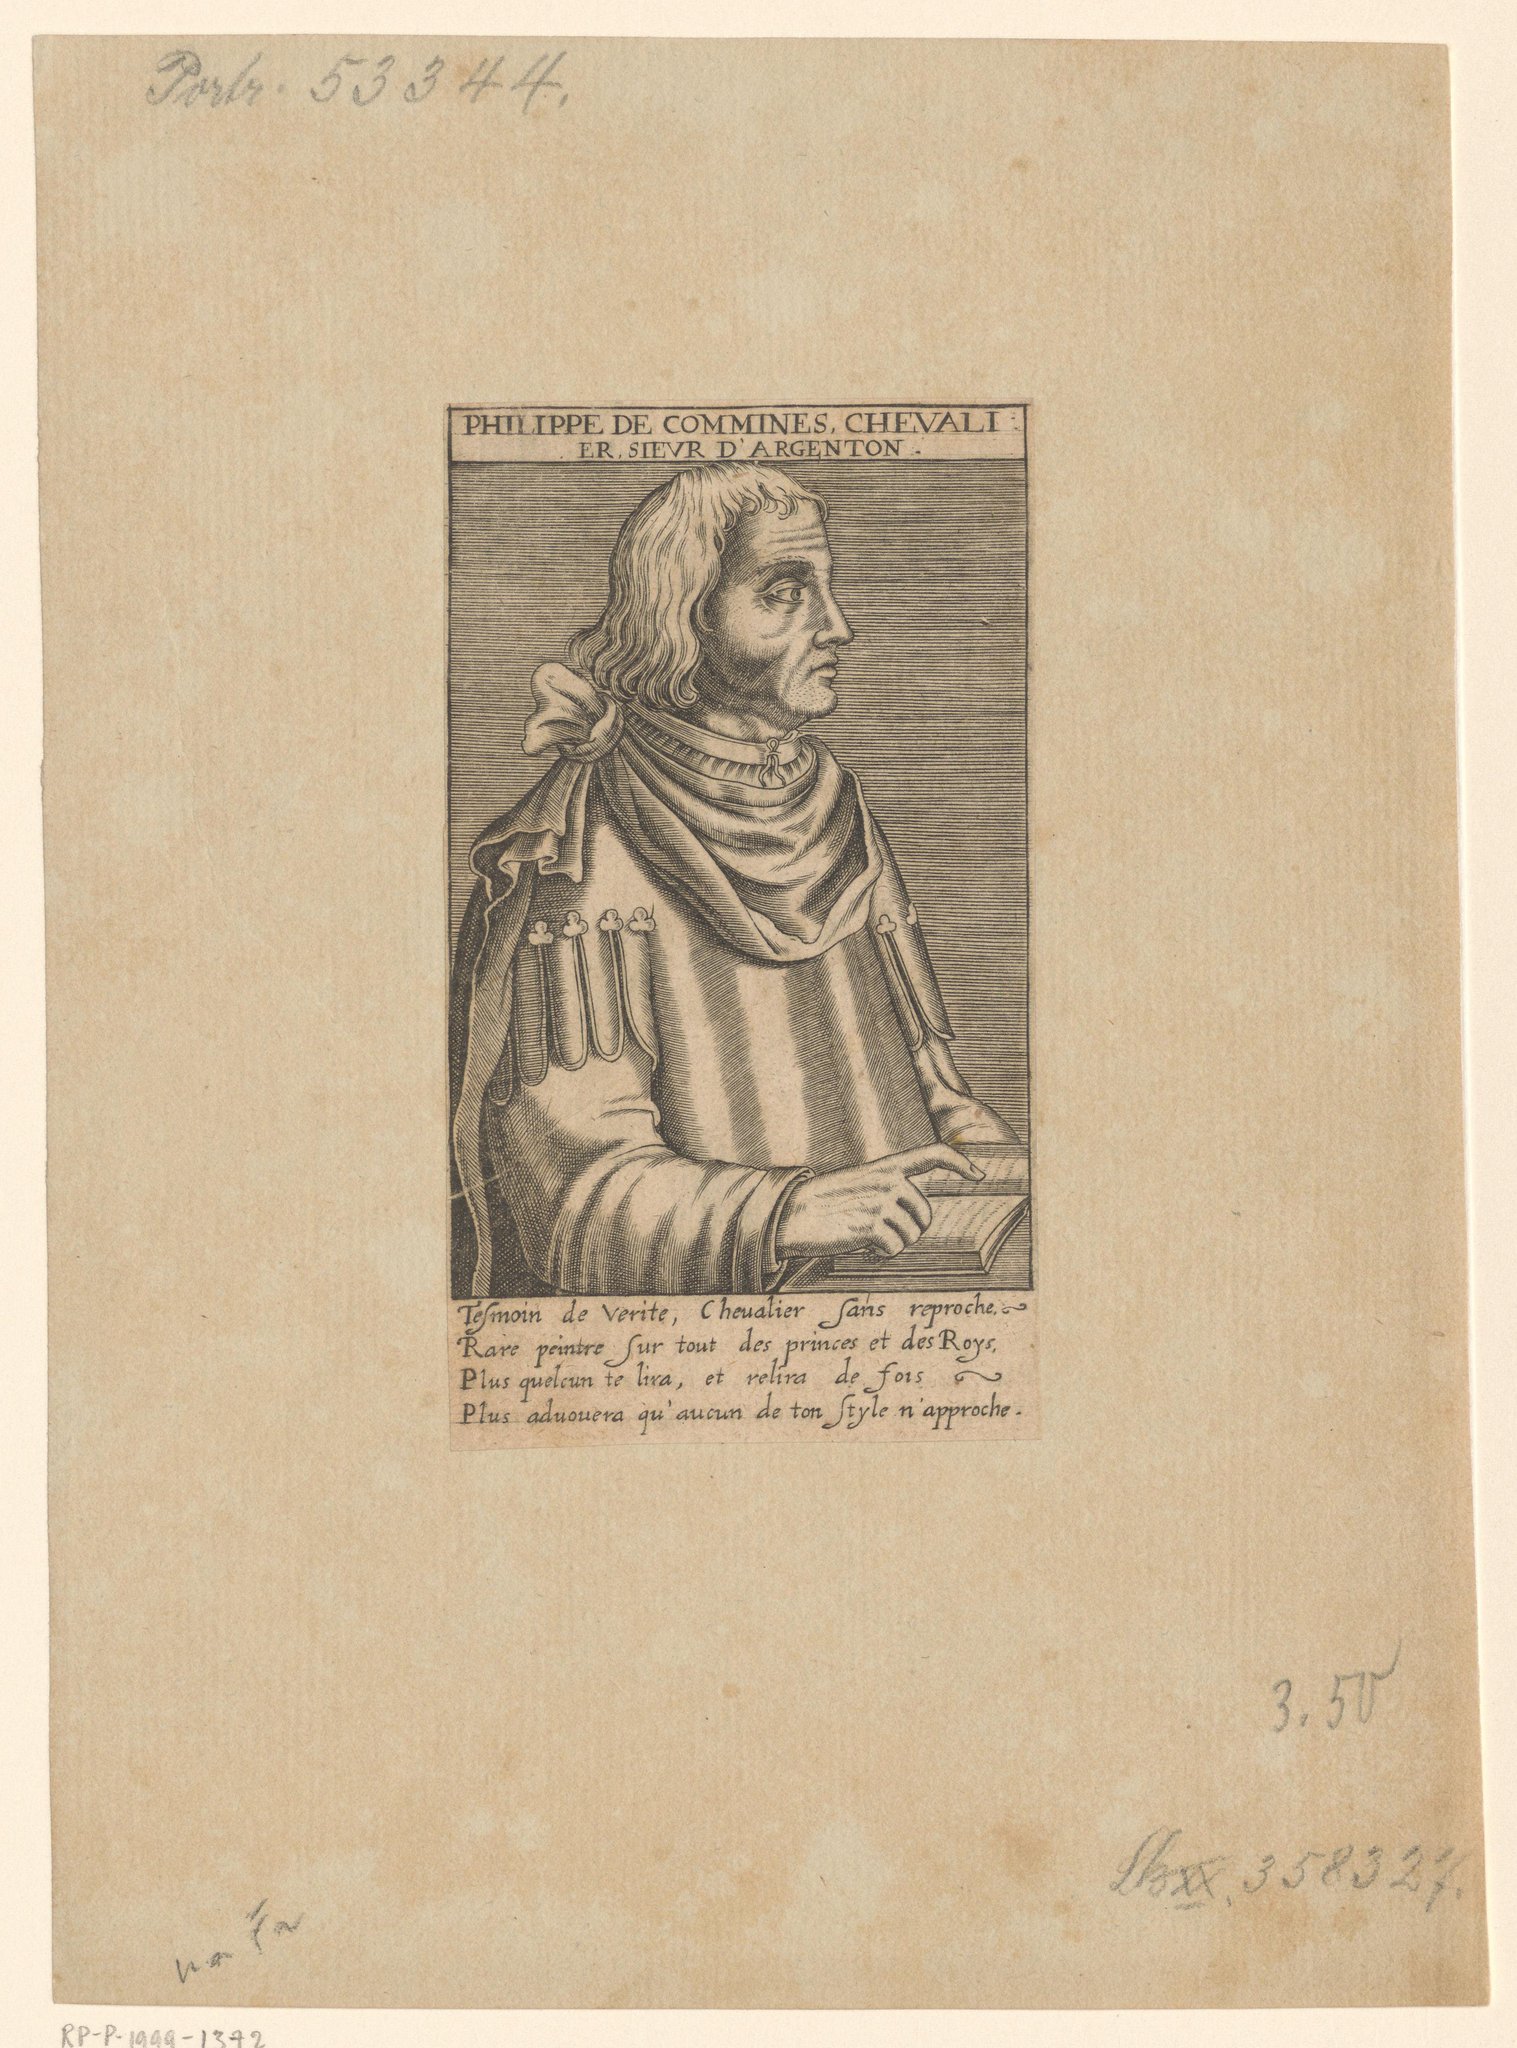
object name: print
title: Portret van Filips van Komen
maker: Anonymous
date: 1613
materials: paper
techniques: engraving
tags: historical persons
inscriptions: collector's mark: Lugt 2760, collector's mark: Lugt 2228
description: Prent mogelijk uit: Les memoires de Philippe de Commines, chevalier, seigneur d'Argenton. Parijs: Claude de Monstr'oeil, 1613.